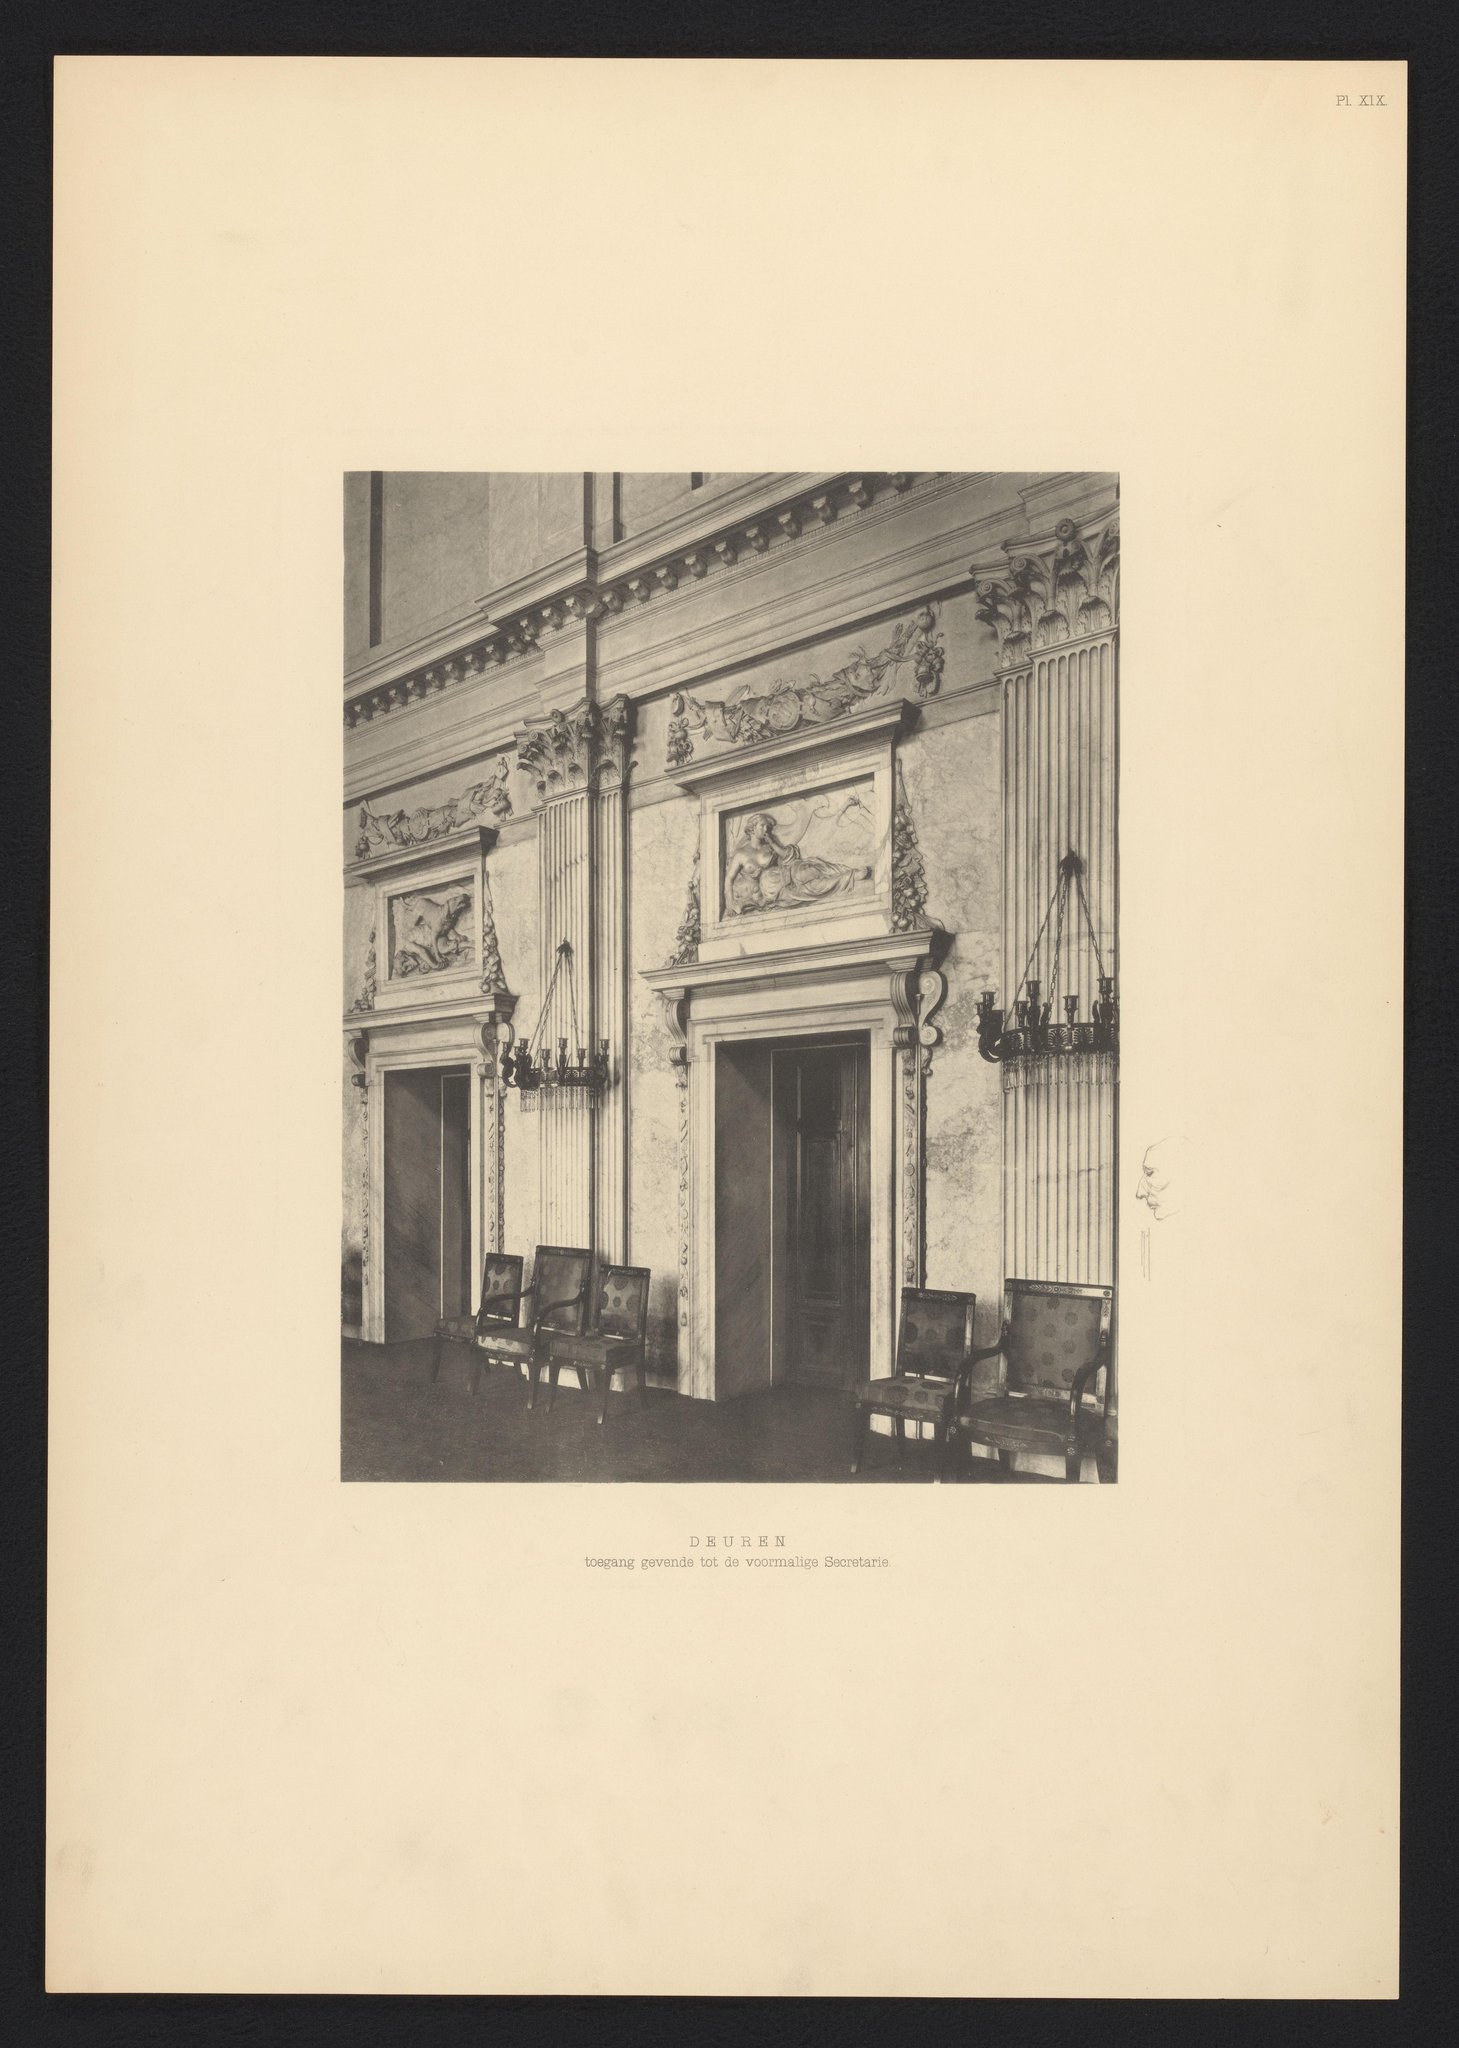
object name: photograph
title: Galerij met deuren die toegang geven tot de secretarie, Paleis op de Dam, Amsterdam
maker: Anonymous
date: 1899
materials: cardboard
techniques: photograph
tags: palace, door, gallery (spacious corridor), royal palace of amsterdam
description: Deuren / toegang gevende tot de voormalige Secretarie.